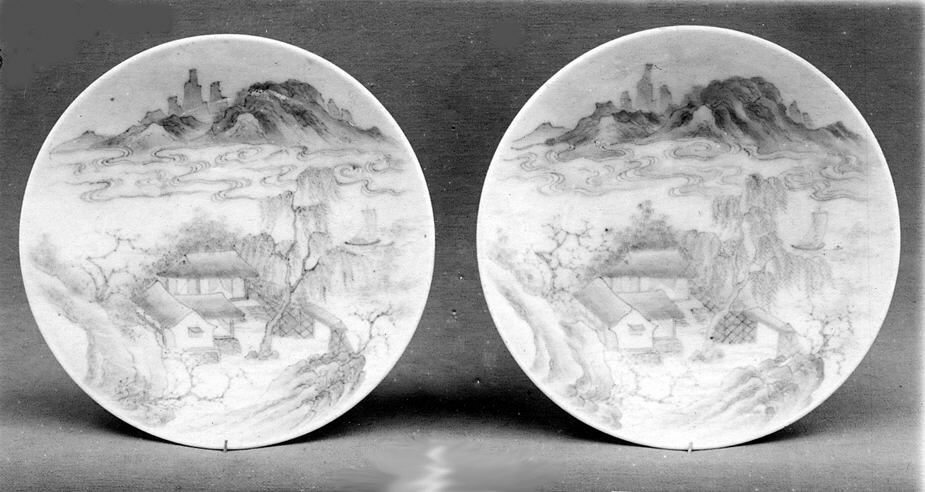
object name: saucer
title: Saucer with Landscape Design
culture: japanese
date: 1800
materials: porcelain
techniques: underglaze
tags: landscapes